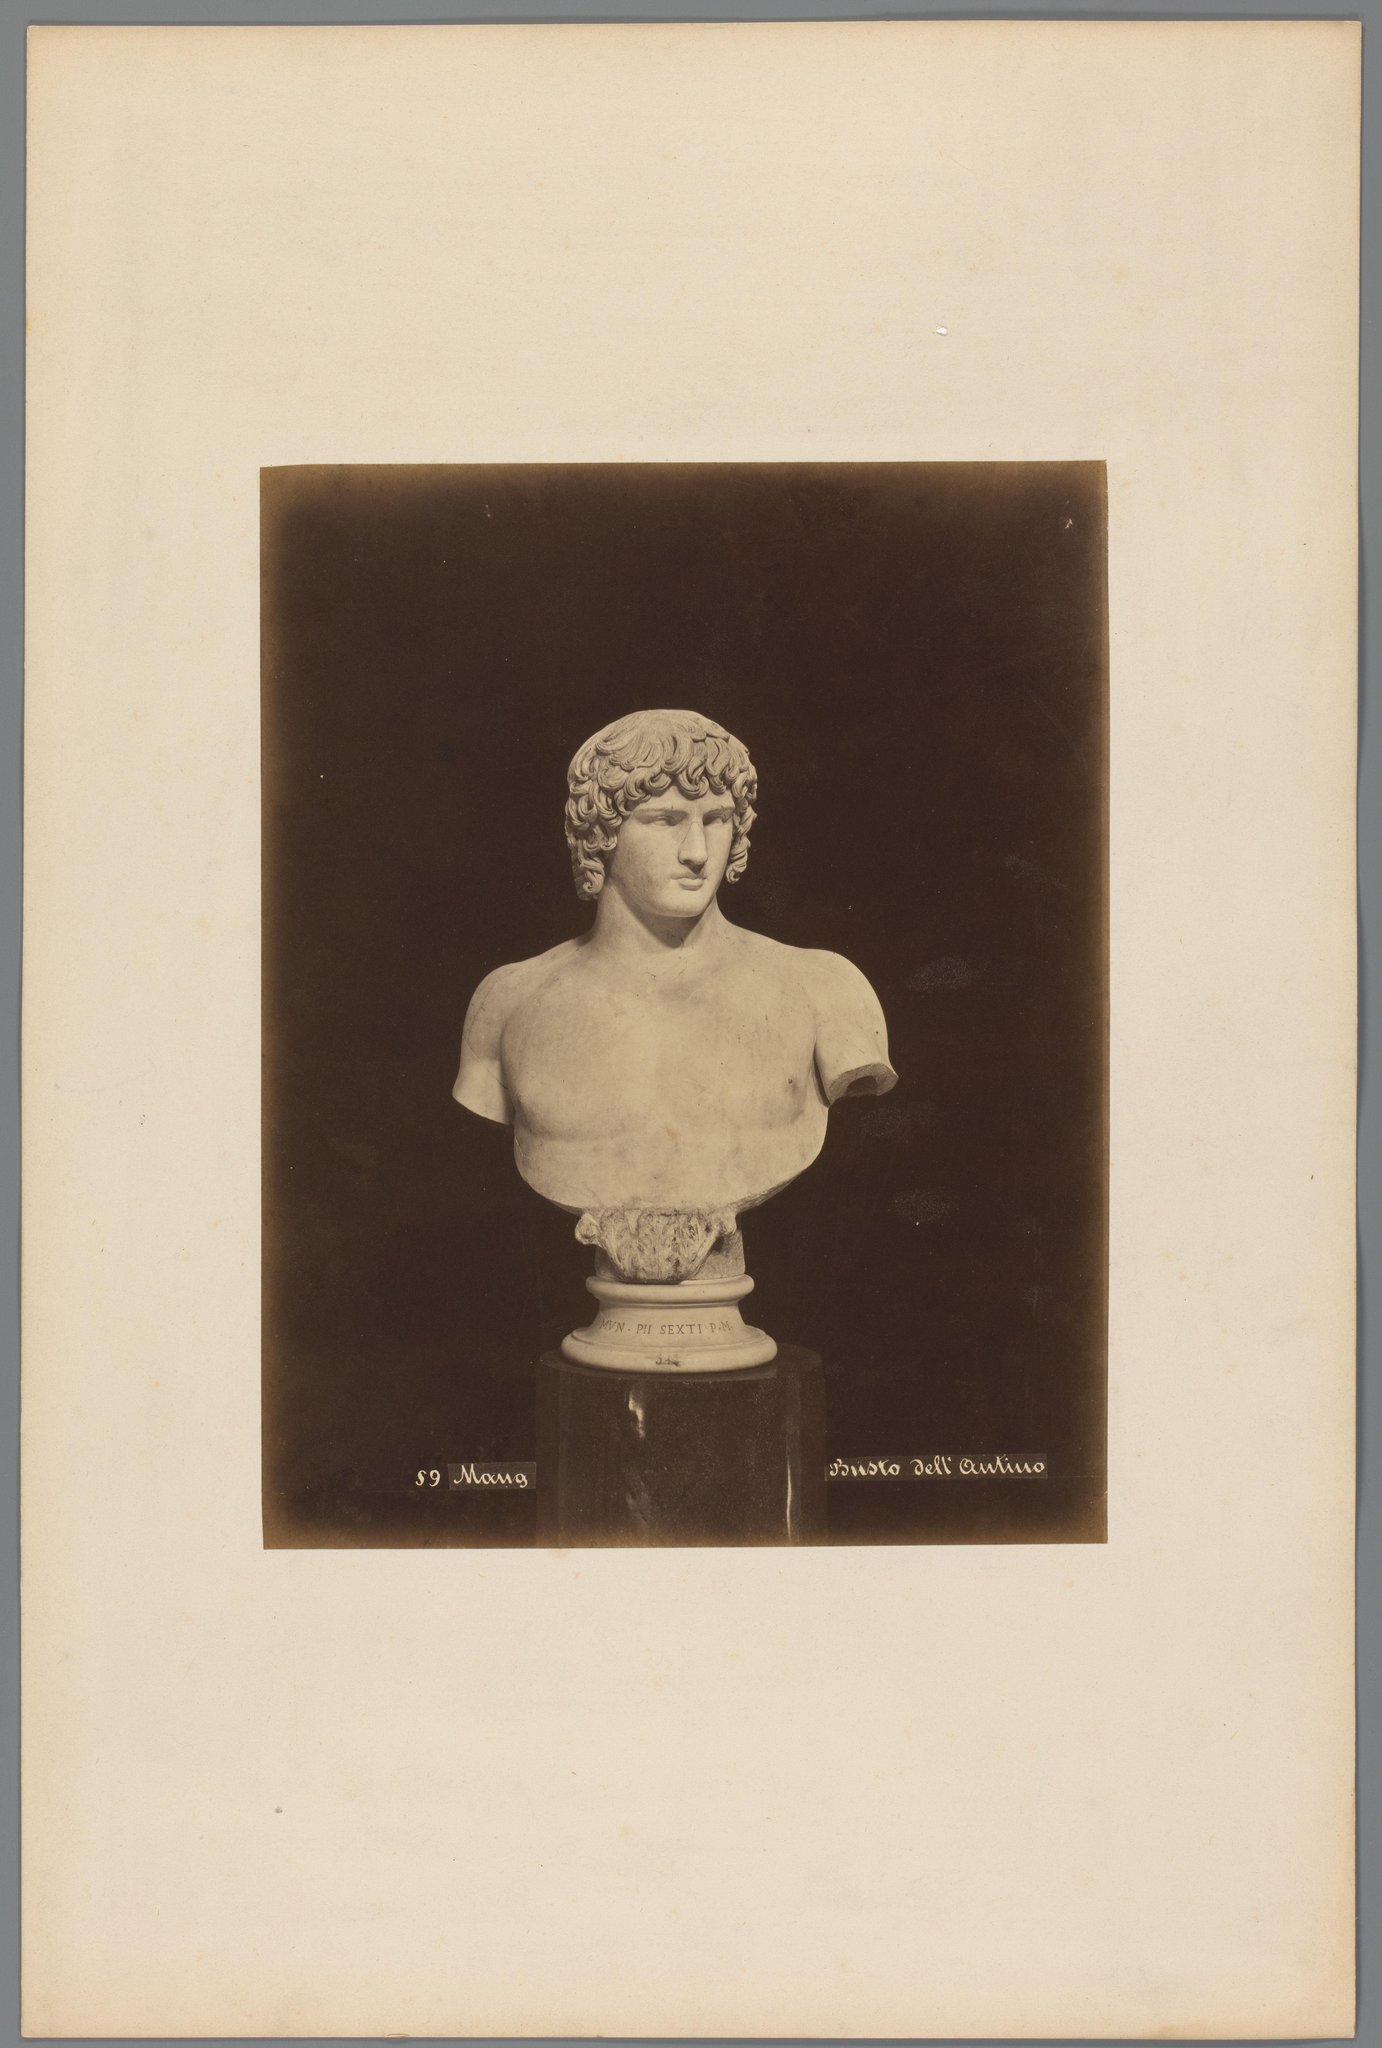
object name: photograph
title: Busto dell'Autino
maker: michèle mang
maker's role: fotograaf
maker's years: 1840-1909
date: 1863-1887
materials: cardboard, paper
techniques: albumen print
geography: vatican city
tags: head (human), piece of sculpture, reproduction of a piece of sculpture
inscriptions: number: ‘89’